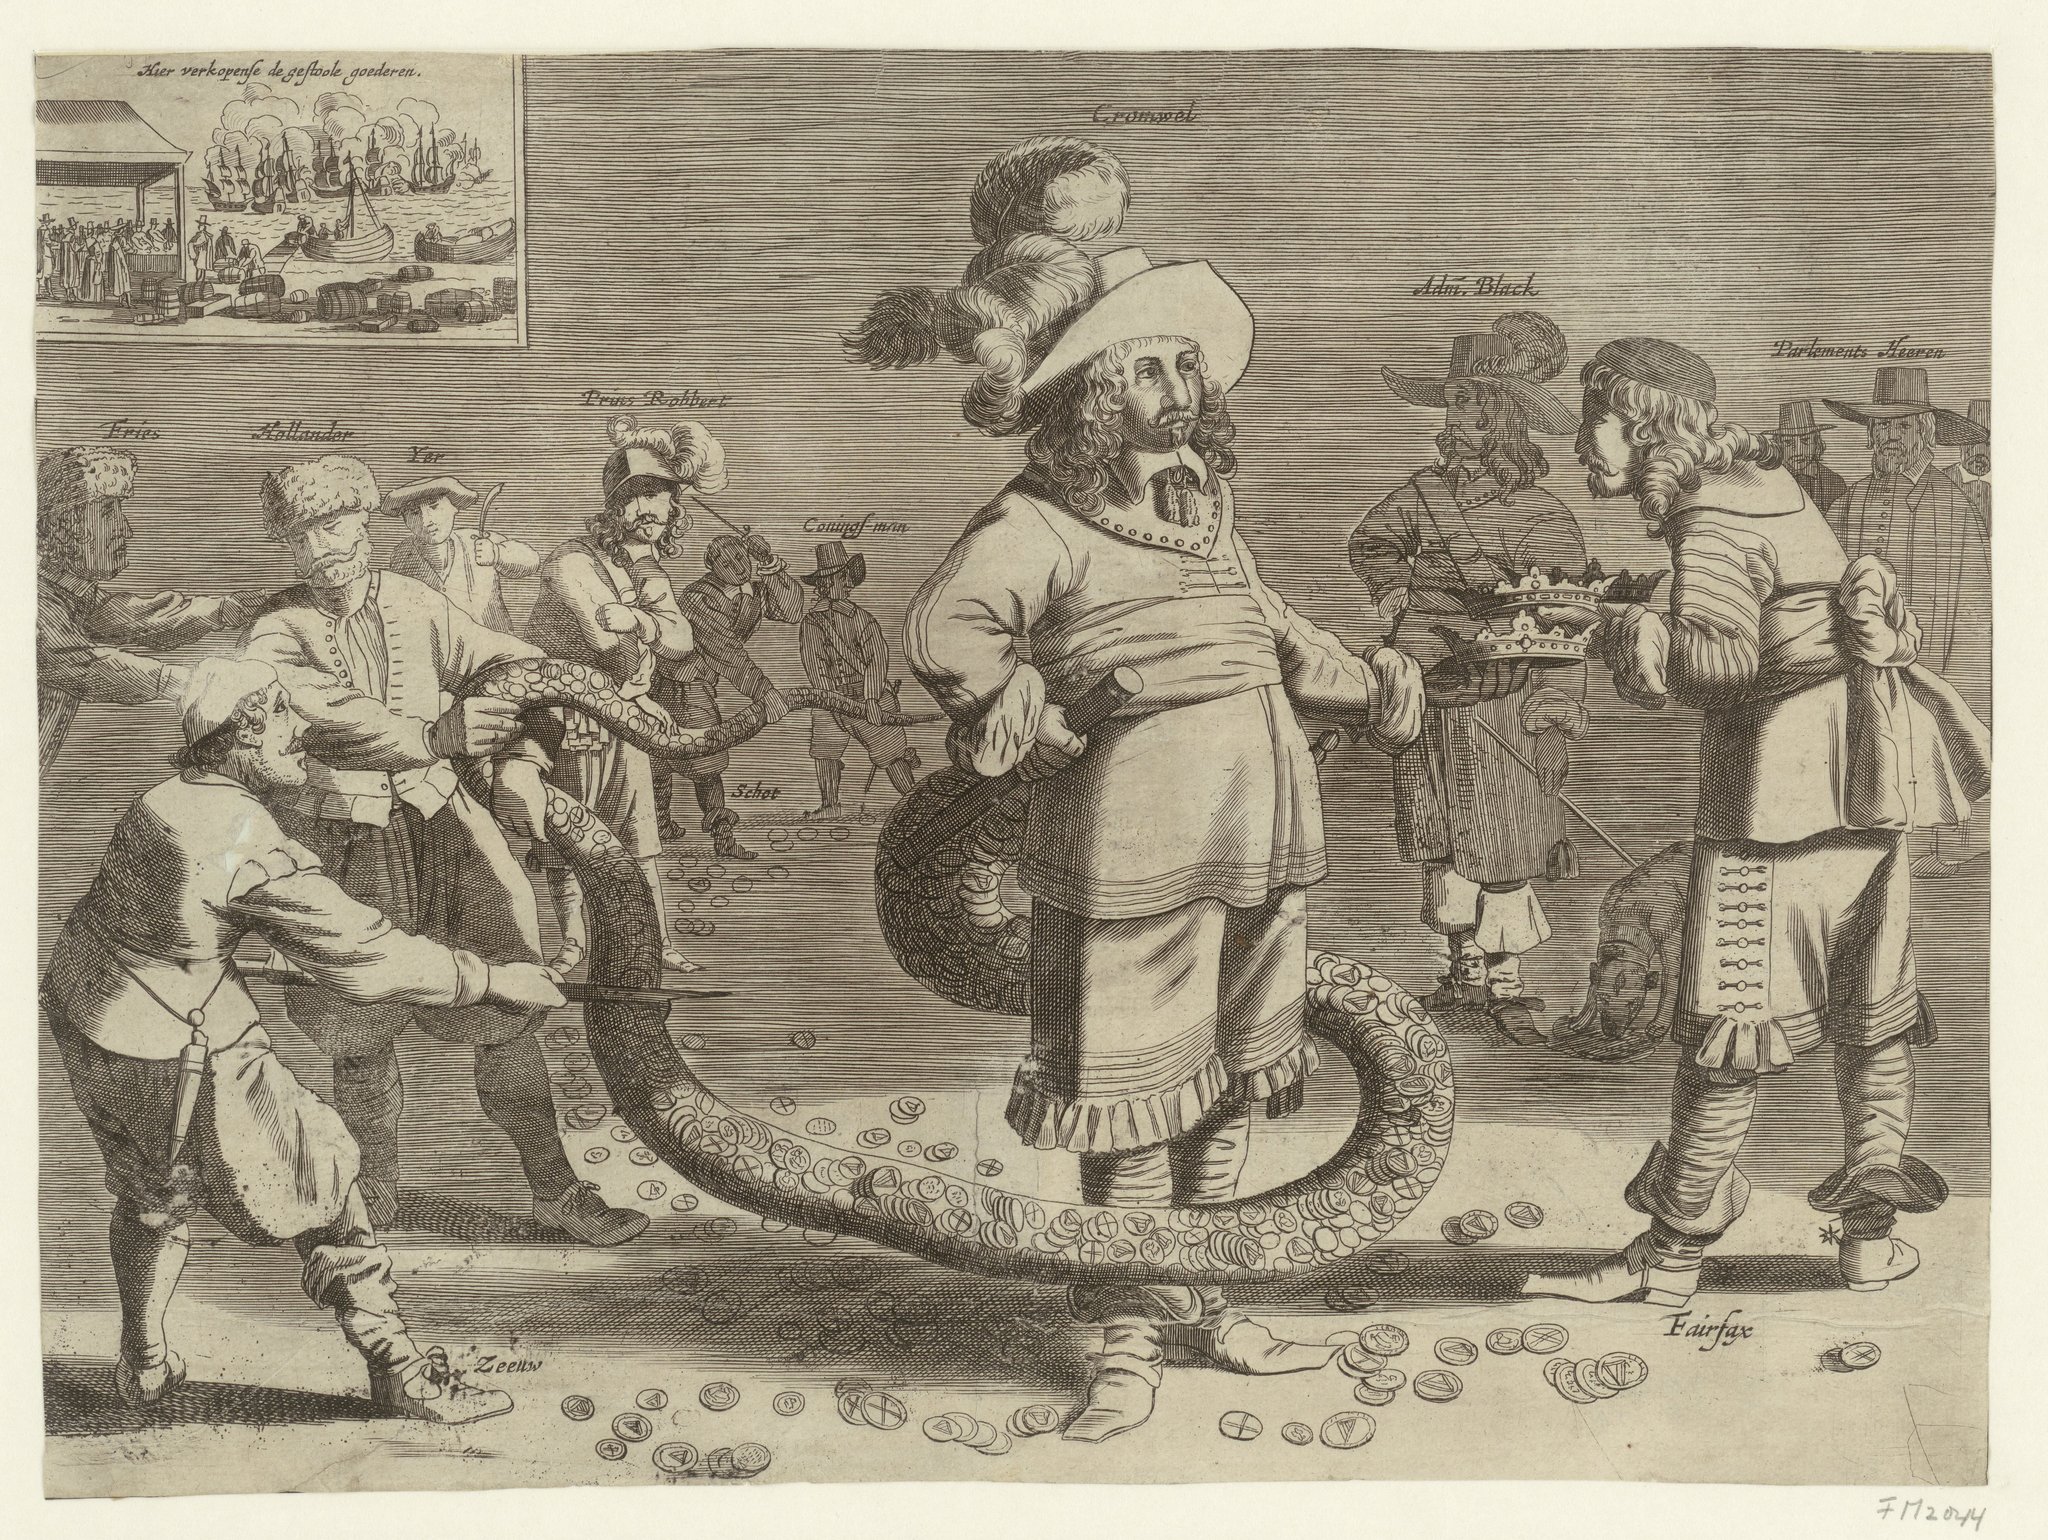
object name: print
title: Spotprent op Cromwell als de afgrijselijke Staartman, 1652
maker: Anonymous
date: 1652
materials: paper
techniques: engraving, etching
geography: northern netherlands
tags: prague, painter, print maker, draughtsman, prinz ruprecht, london, oliver cromwell, political caricatures and satires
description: Spotprent op Cromwell als de afgrijselijke Staartman, 1652. Oliver Cromwell met een lange slangenstaart gevuld met geldstukken. Rechts biedt Fairfax hem drie kronen aan. Op de achtergrond admiraal Blake en leden van het Engelse parlement. Links snijden een Hollander en een Zeeuw de staart door, hierbij geholpen door een Fries, een Ier, prins Ruprecht, een Schot en een koningsman (royalist). Linksboven een kleine scène van het door de Engelsen verkopen van gestolen goederen. Exemplaar zonder het bijbehorende tekstblad.